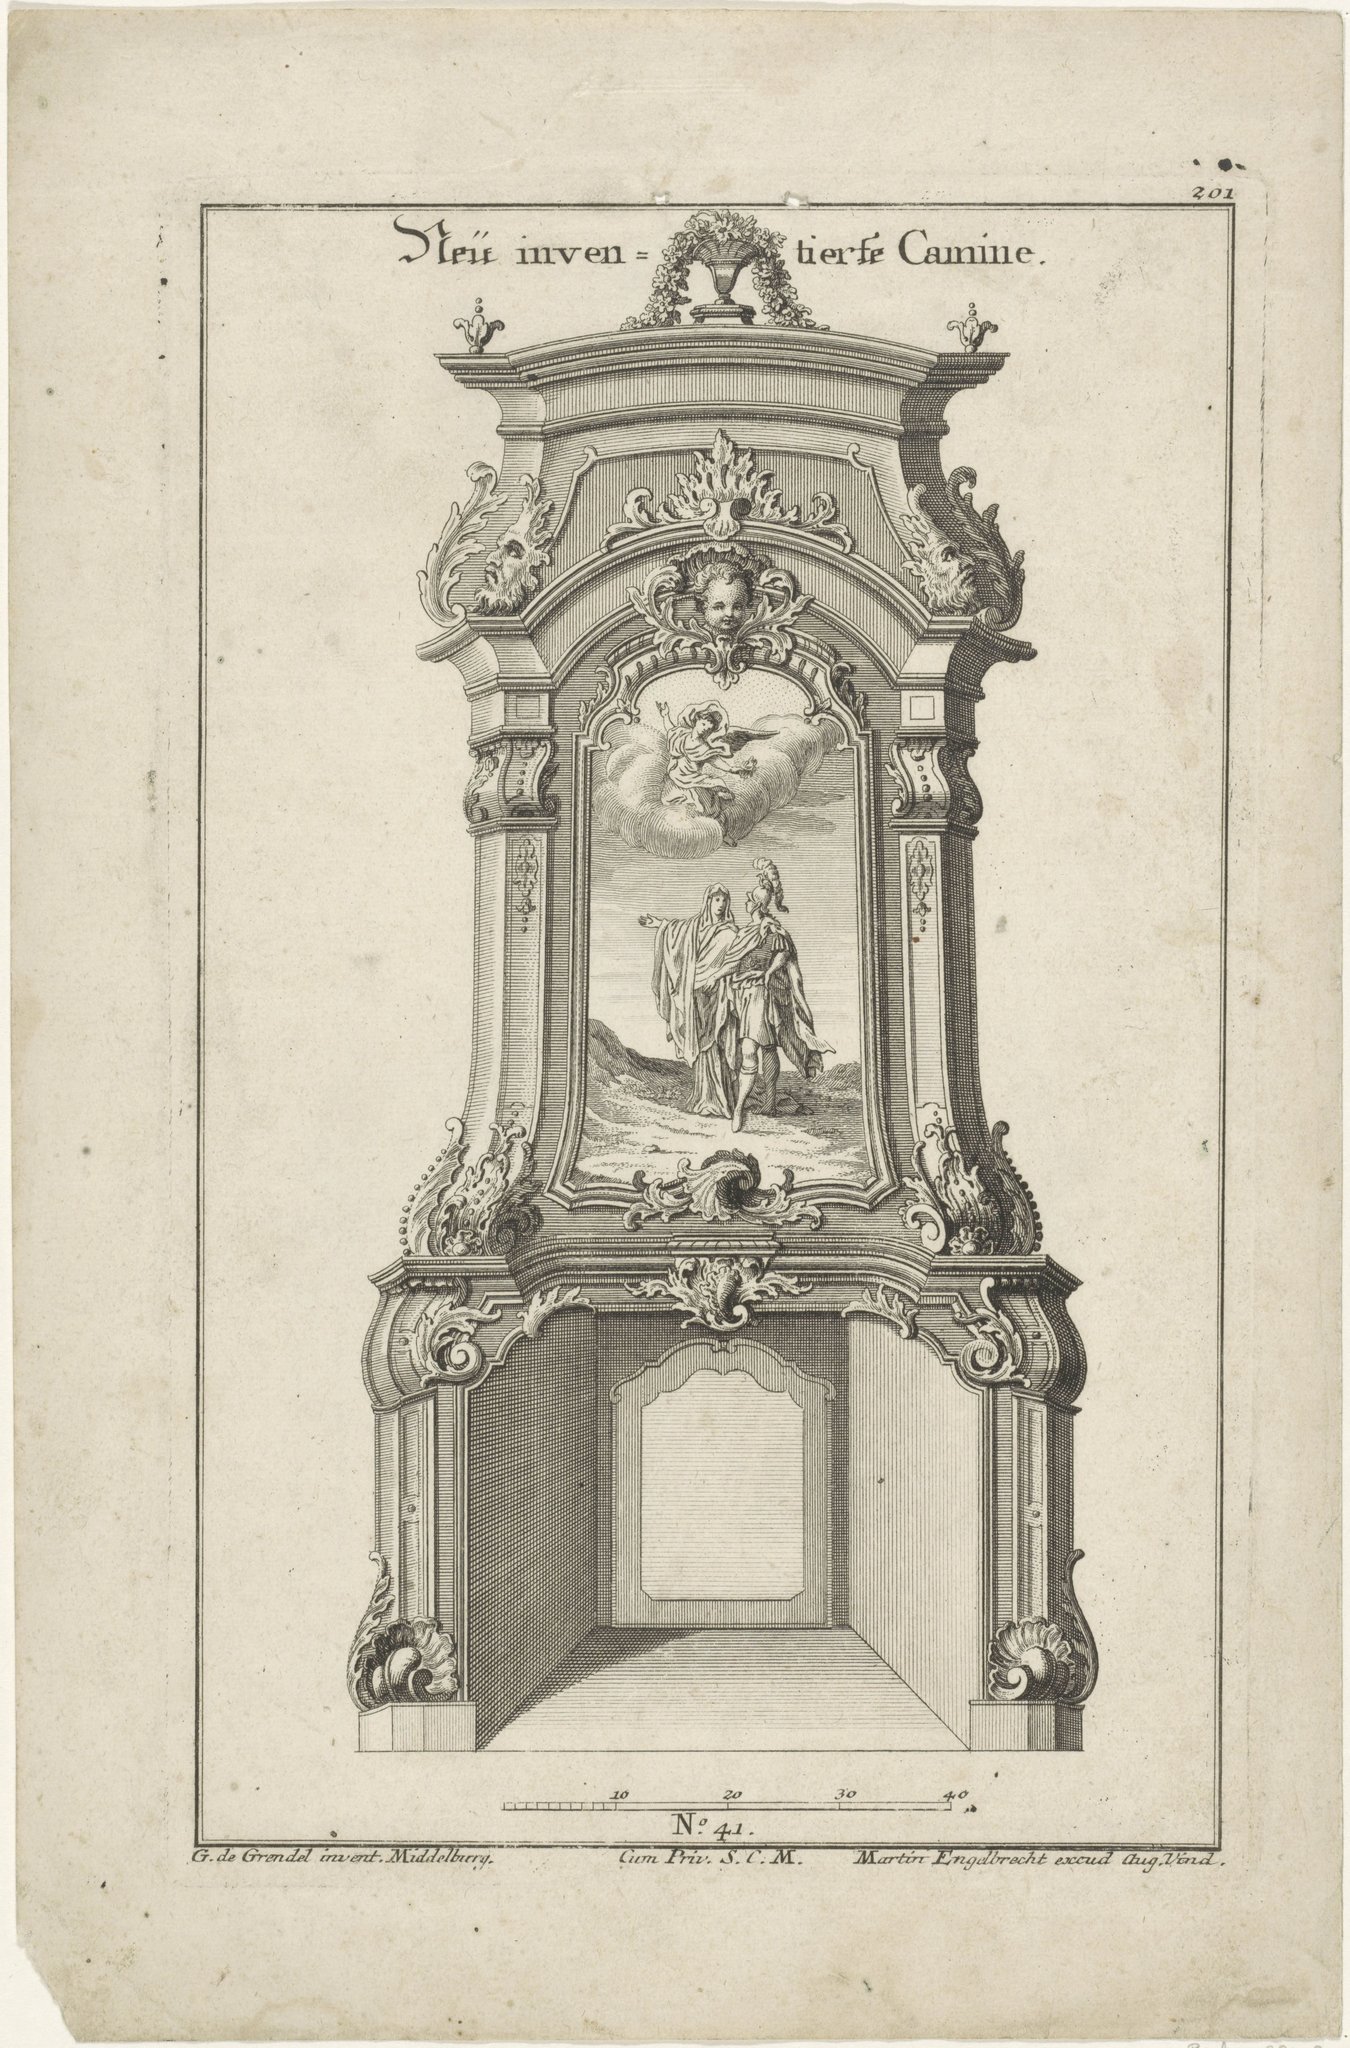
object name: ornament print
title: Friezen met grotesken, putti en bladranken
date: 1510-1544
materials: paper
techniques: engraving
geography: germany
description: Borstkuras tussen twee putti en bladranken. De putto links wordt op de rug gezien. Gearceerde achtergrond. 1 blad van 4 bladen.